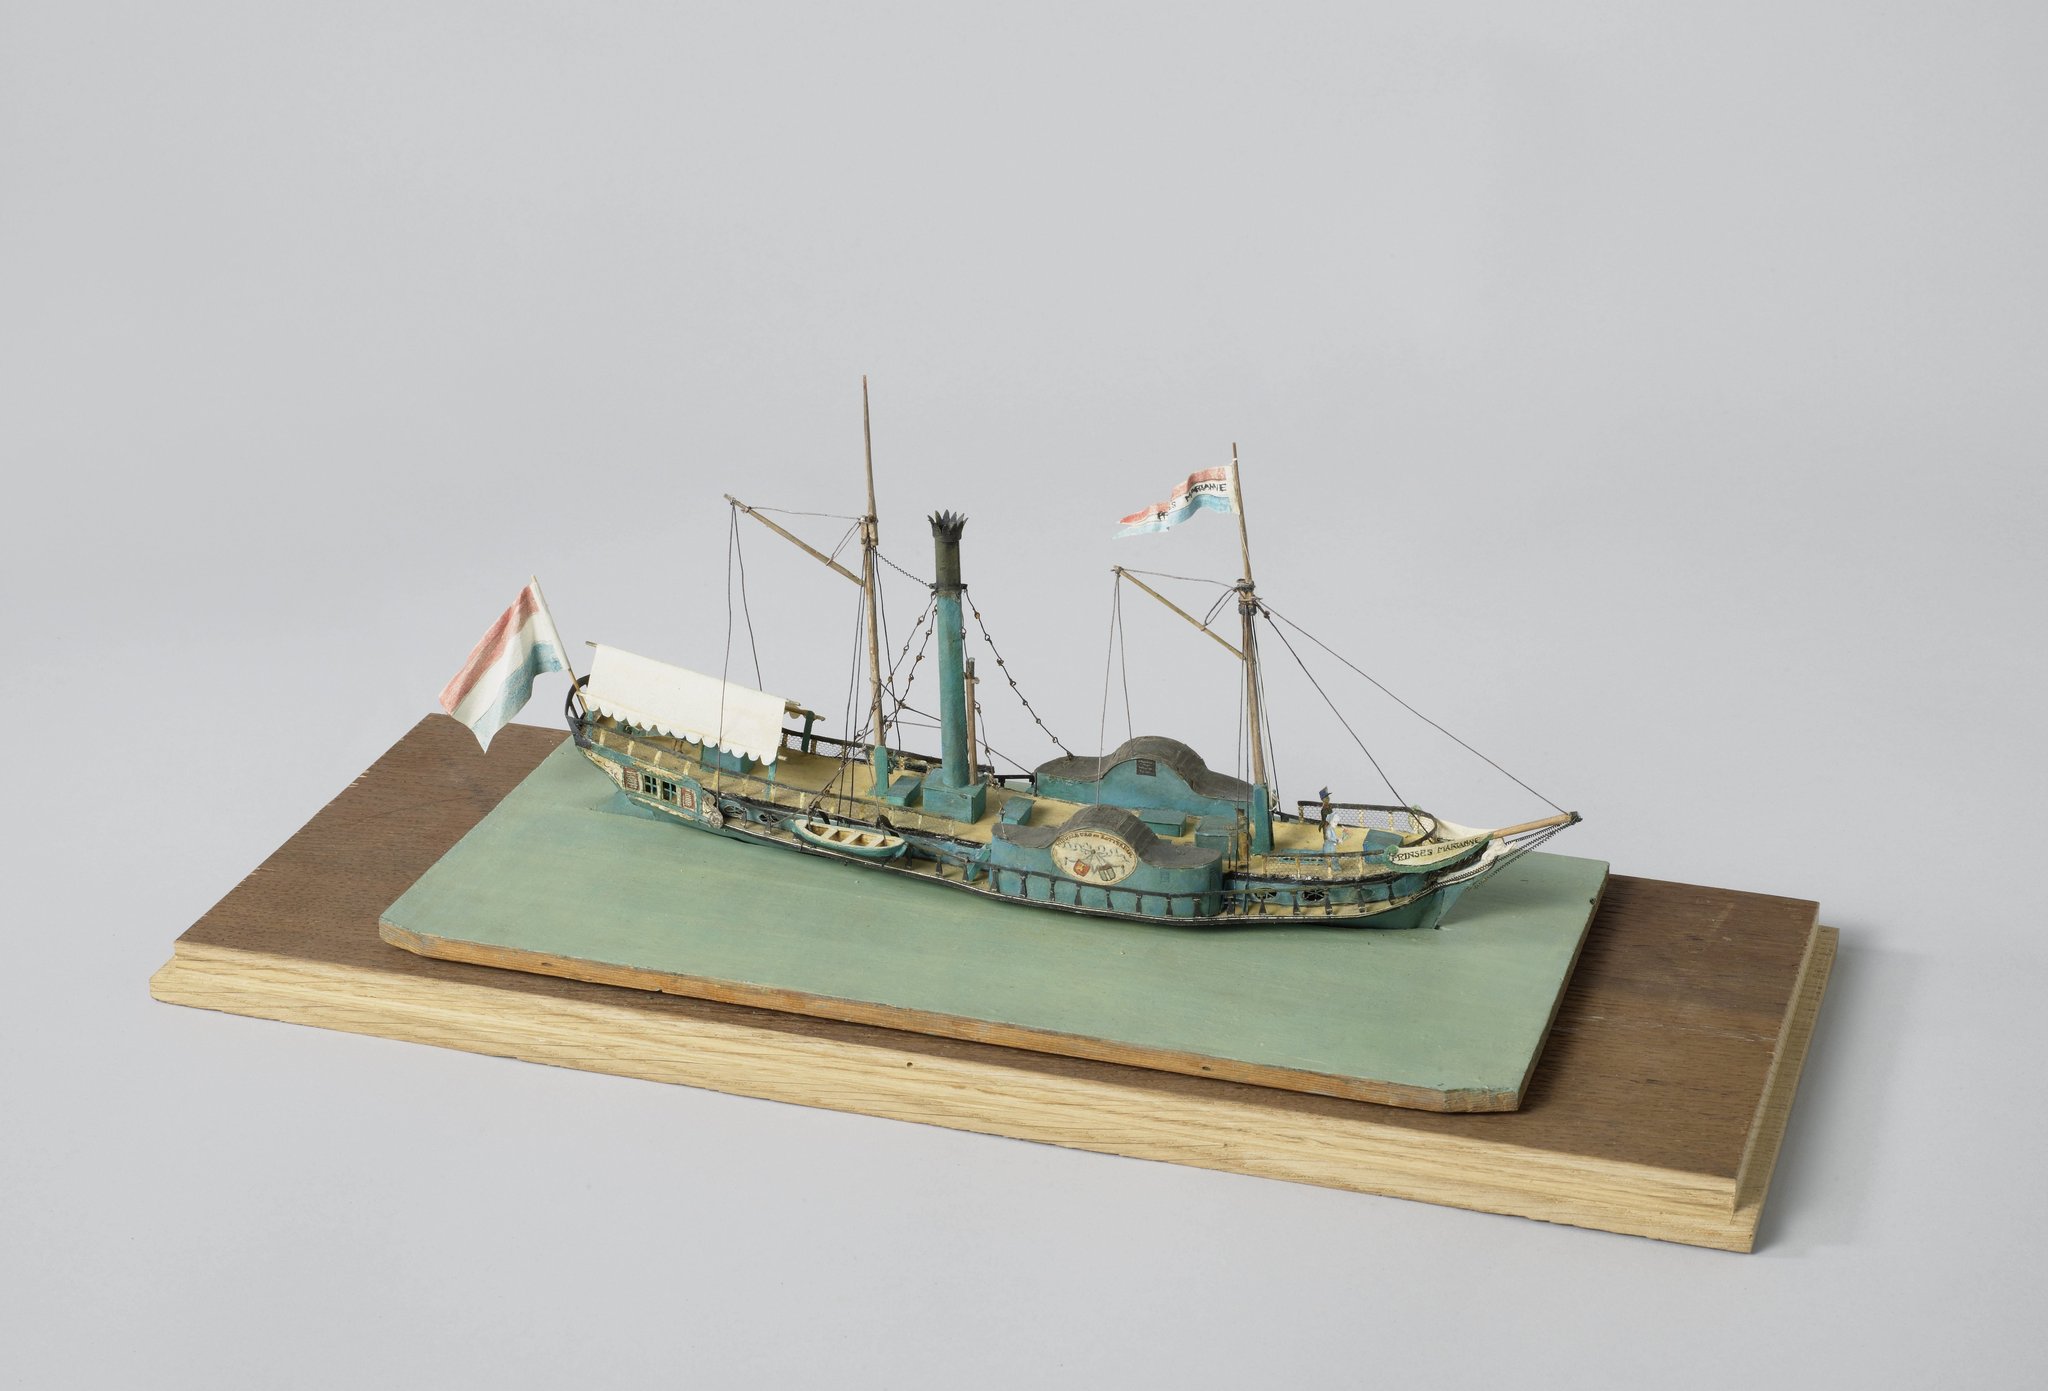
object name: ship model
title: Model of a Paddle Steamer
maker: erdegangh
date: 1820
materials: oil, paper, board, plastic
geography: dordrecht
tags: middelburg, rotterdam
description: Model van bordpapier, voorstellend een stoomboot met twee scheepsraderen. Het model is uitgevoerd met stoompijp, twee masten, waarvan aan de fokkemast een vlag is bevestigd. Midscheeps aan weerszijden hangt een sloep aan de davits. Op het achterdek is een doek gespannen. Op het dek zijn enkele figuurtjes bevestigd die passagiers voorstellen. Het model is bevestigd op houten grondplank die groenblauw is geverfd en water voorstelt.